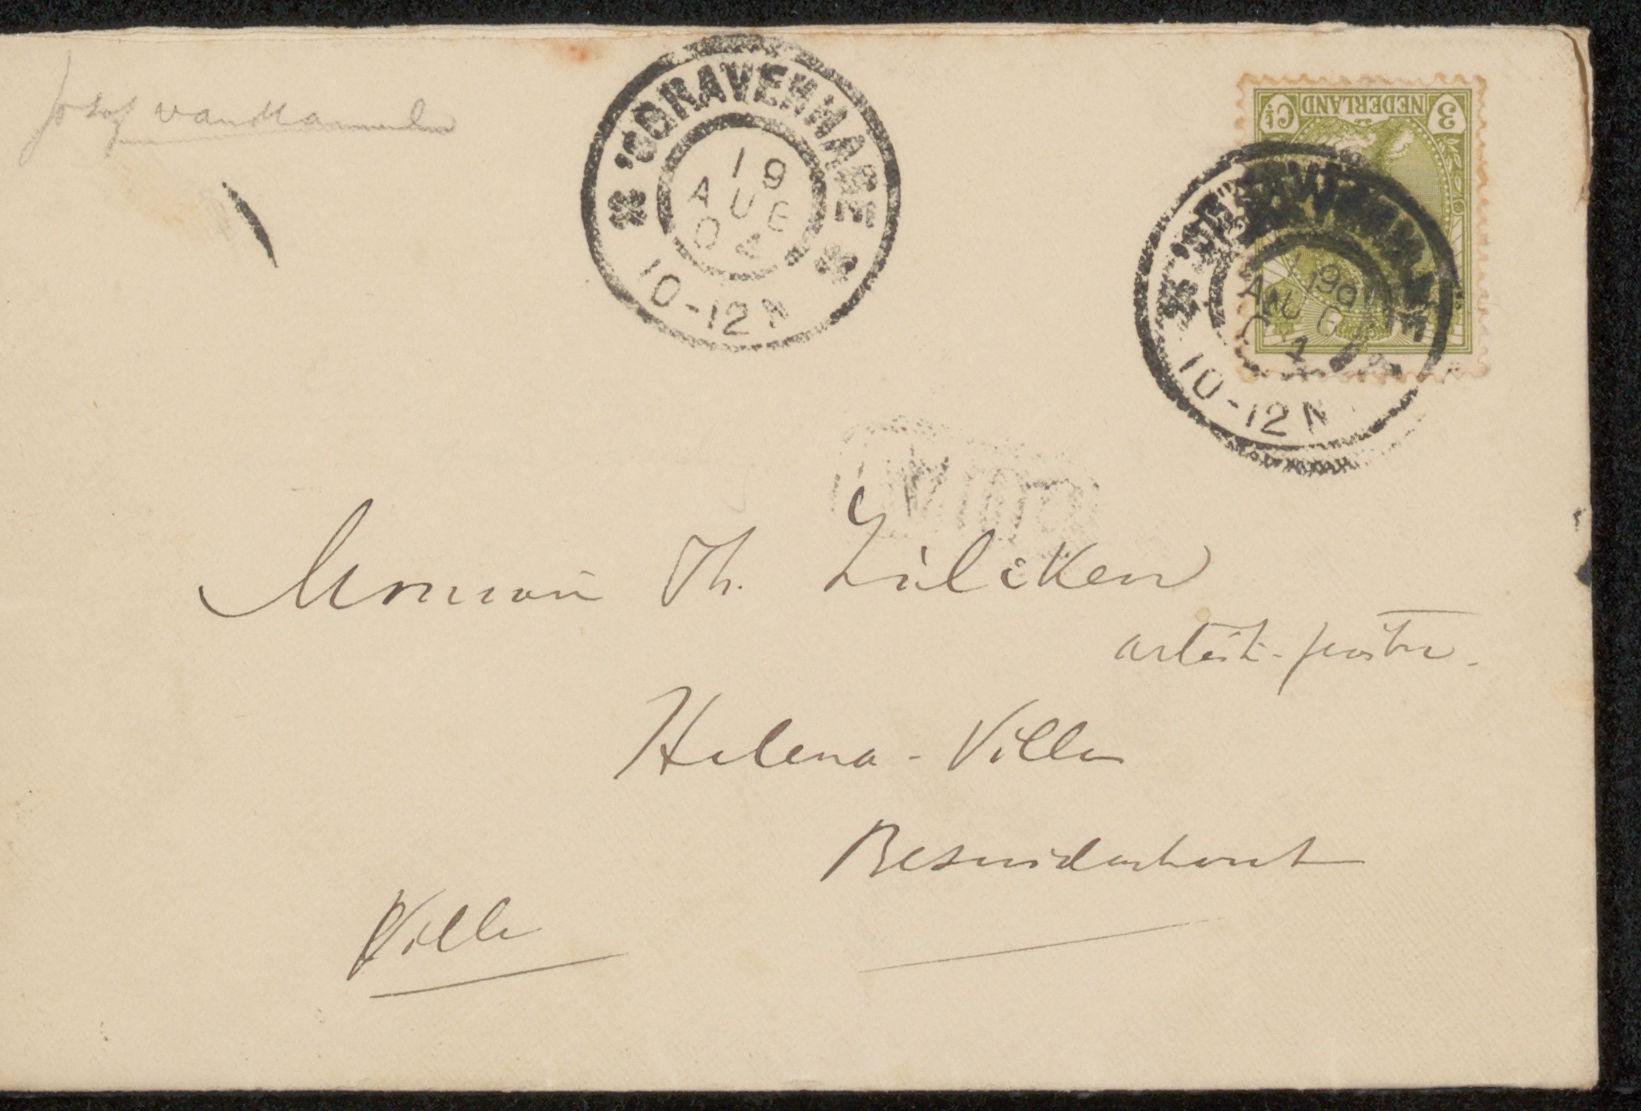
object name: envelope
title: Envelop aan Philip Zilcken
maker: antonius gerardus van hamel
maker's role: hoogleraar, theoloog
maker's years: 1842-1907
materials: ink, paper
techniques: pen, writing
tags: the hague, painter, draughtsman, philip zilcken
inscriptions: collector's mark: ‘RPK’